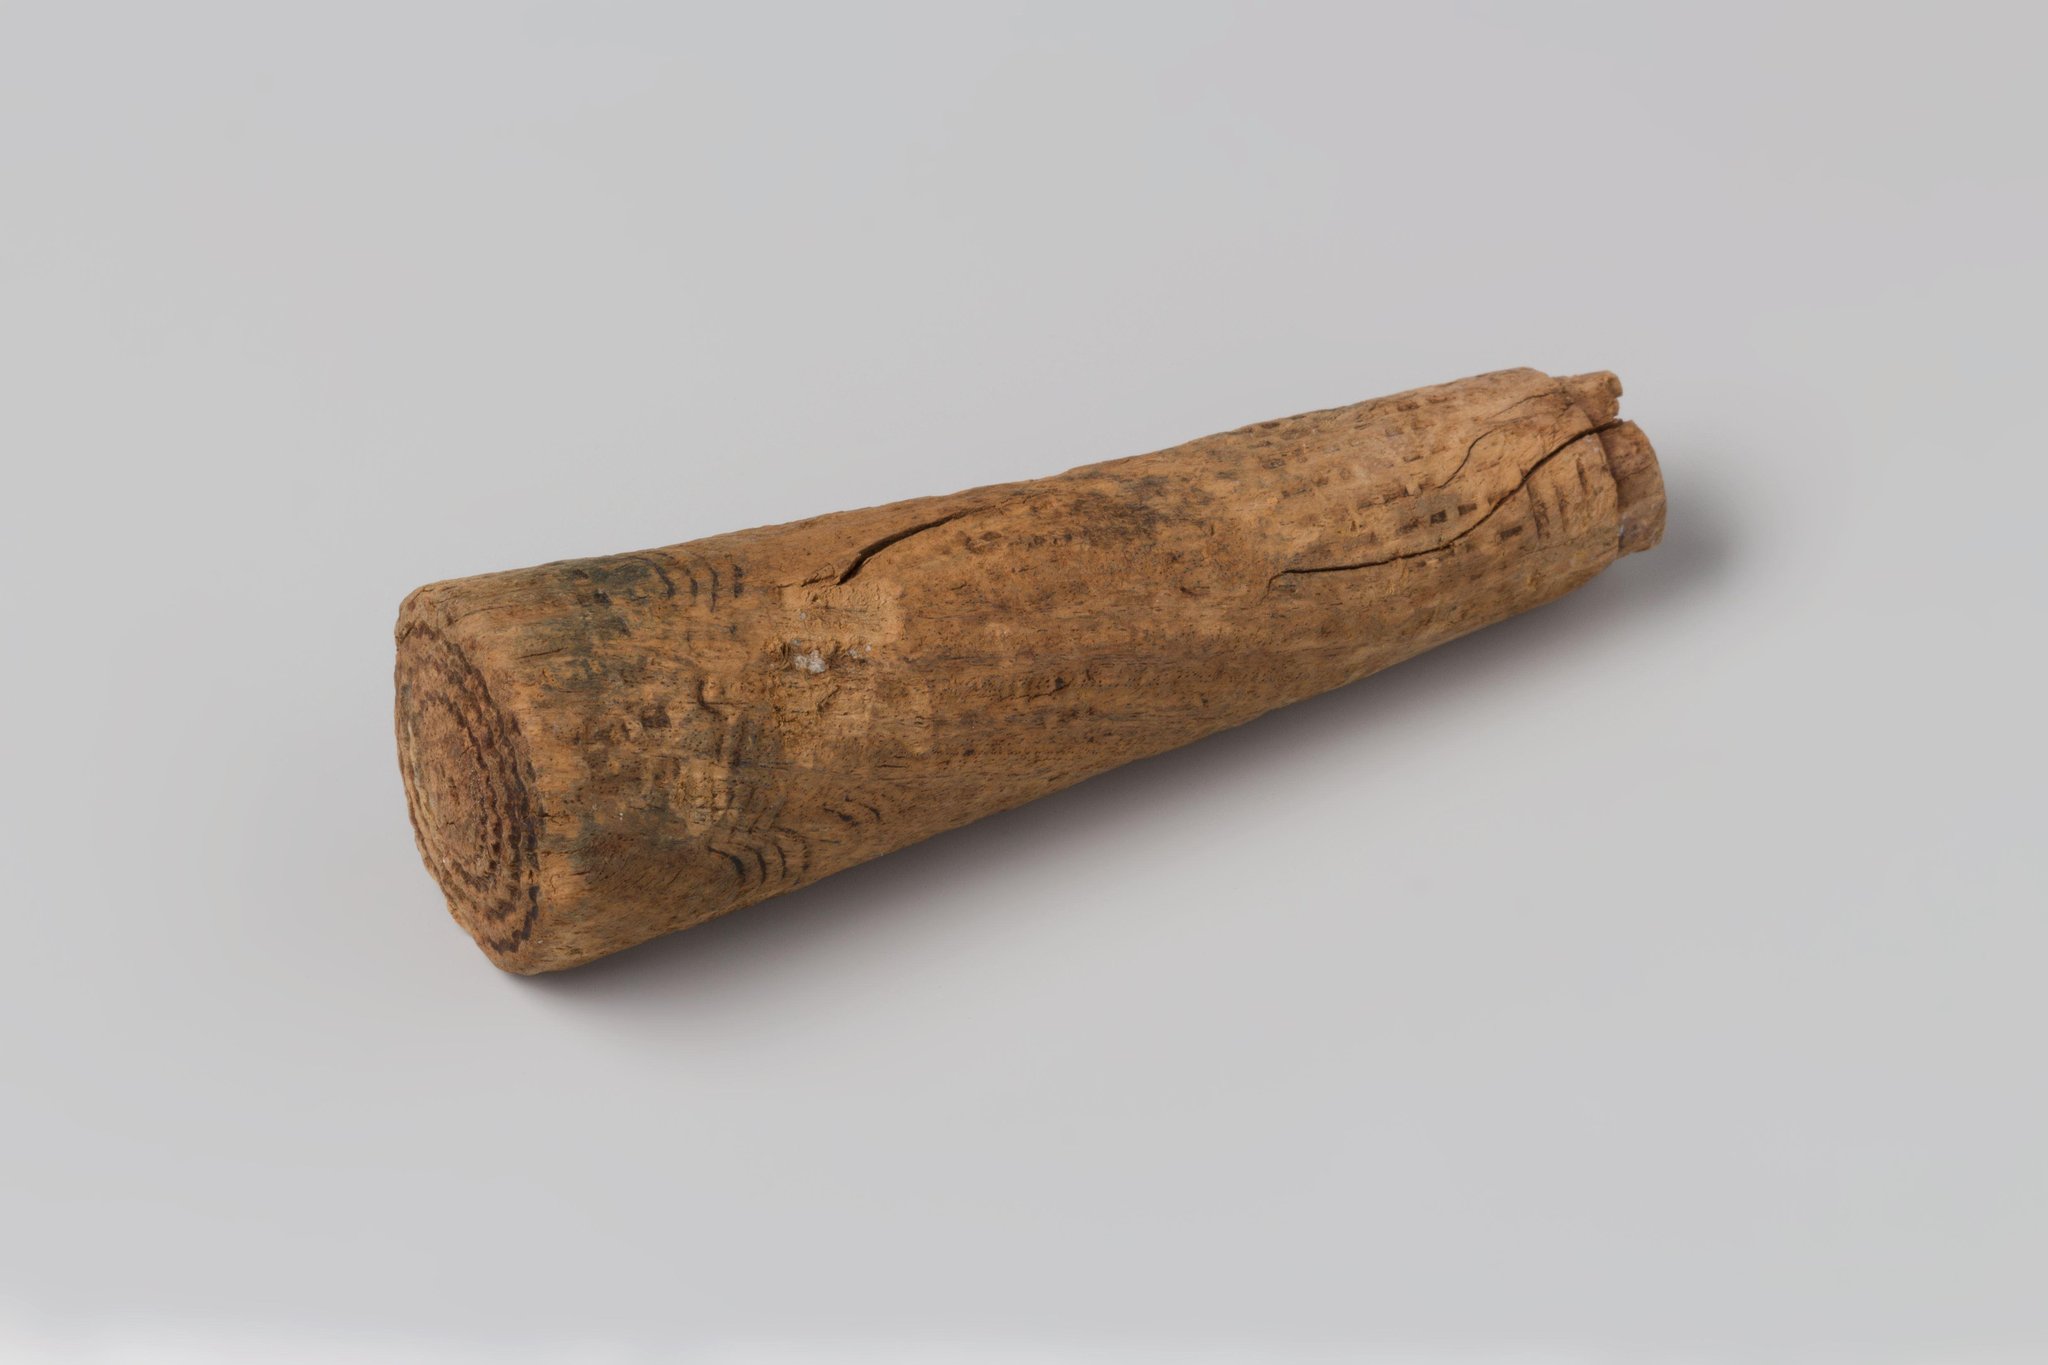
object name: knife handle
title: Messenheft uit het wrak van de Oost-Indiëvaarder Hollandia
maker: Anonymous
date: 1700-1743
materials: wood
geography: netherlands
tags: verenigde oostindische compagnie, hollandia (schip), annet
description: Knife, handle, cylindrical: tapering; id. NG 1979-403H, eroded.